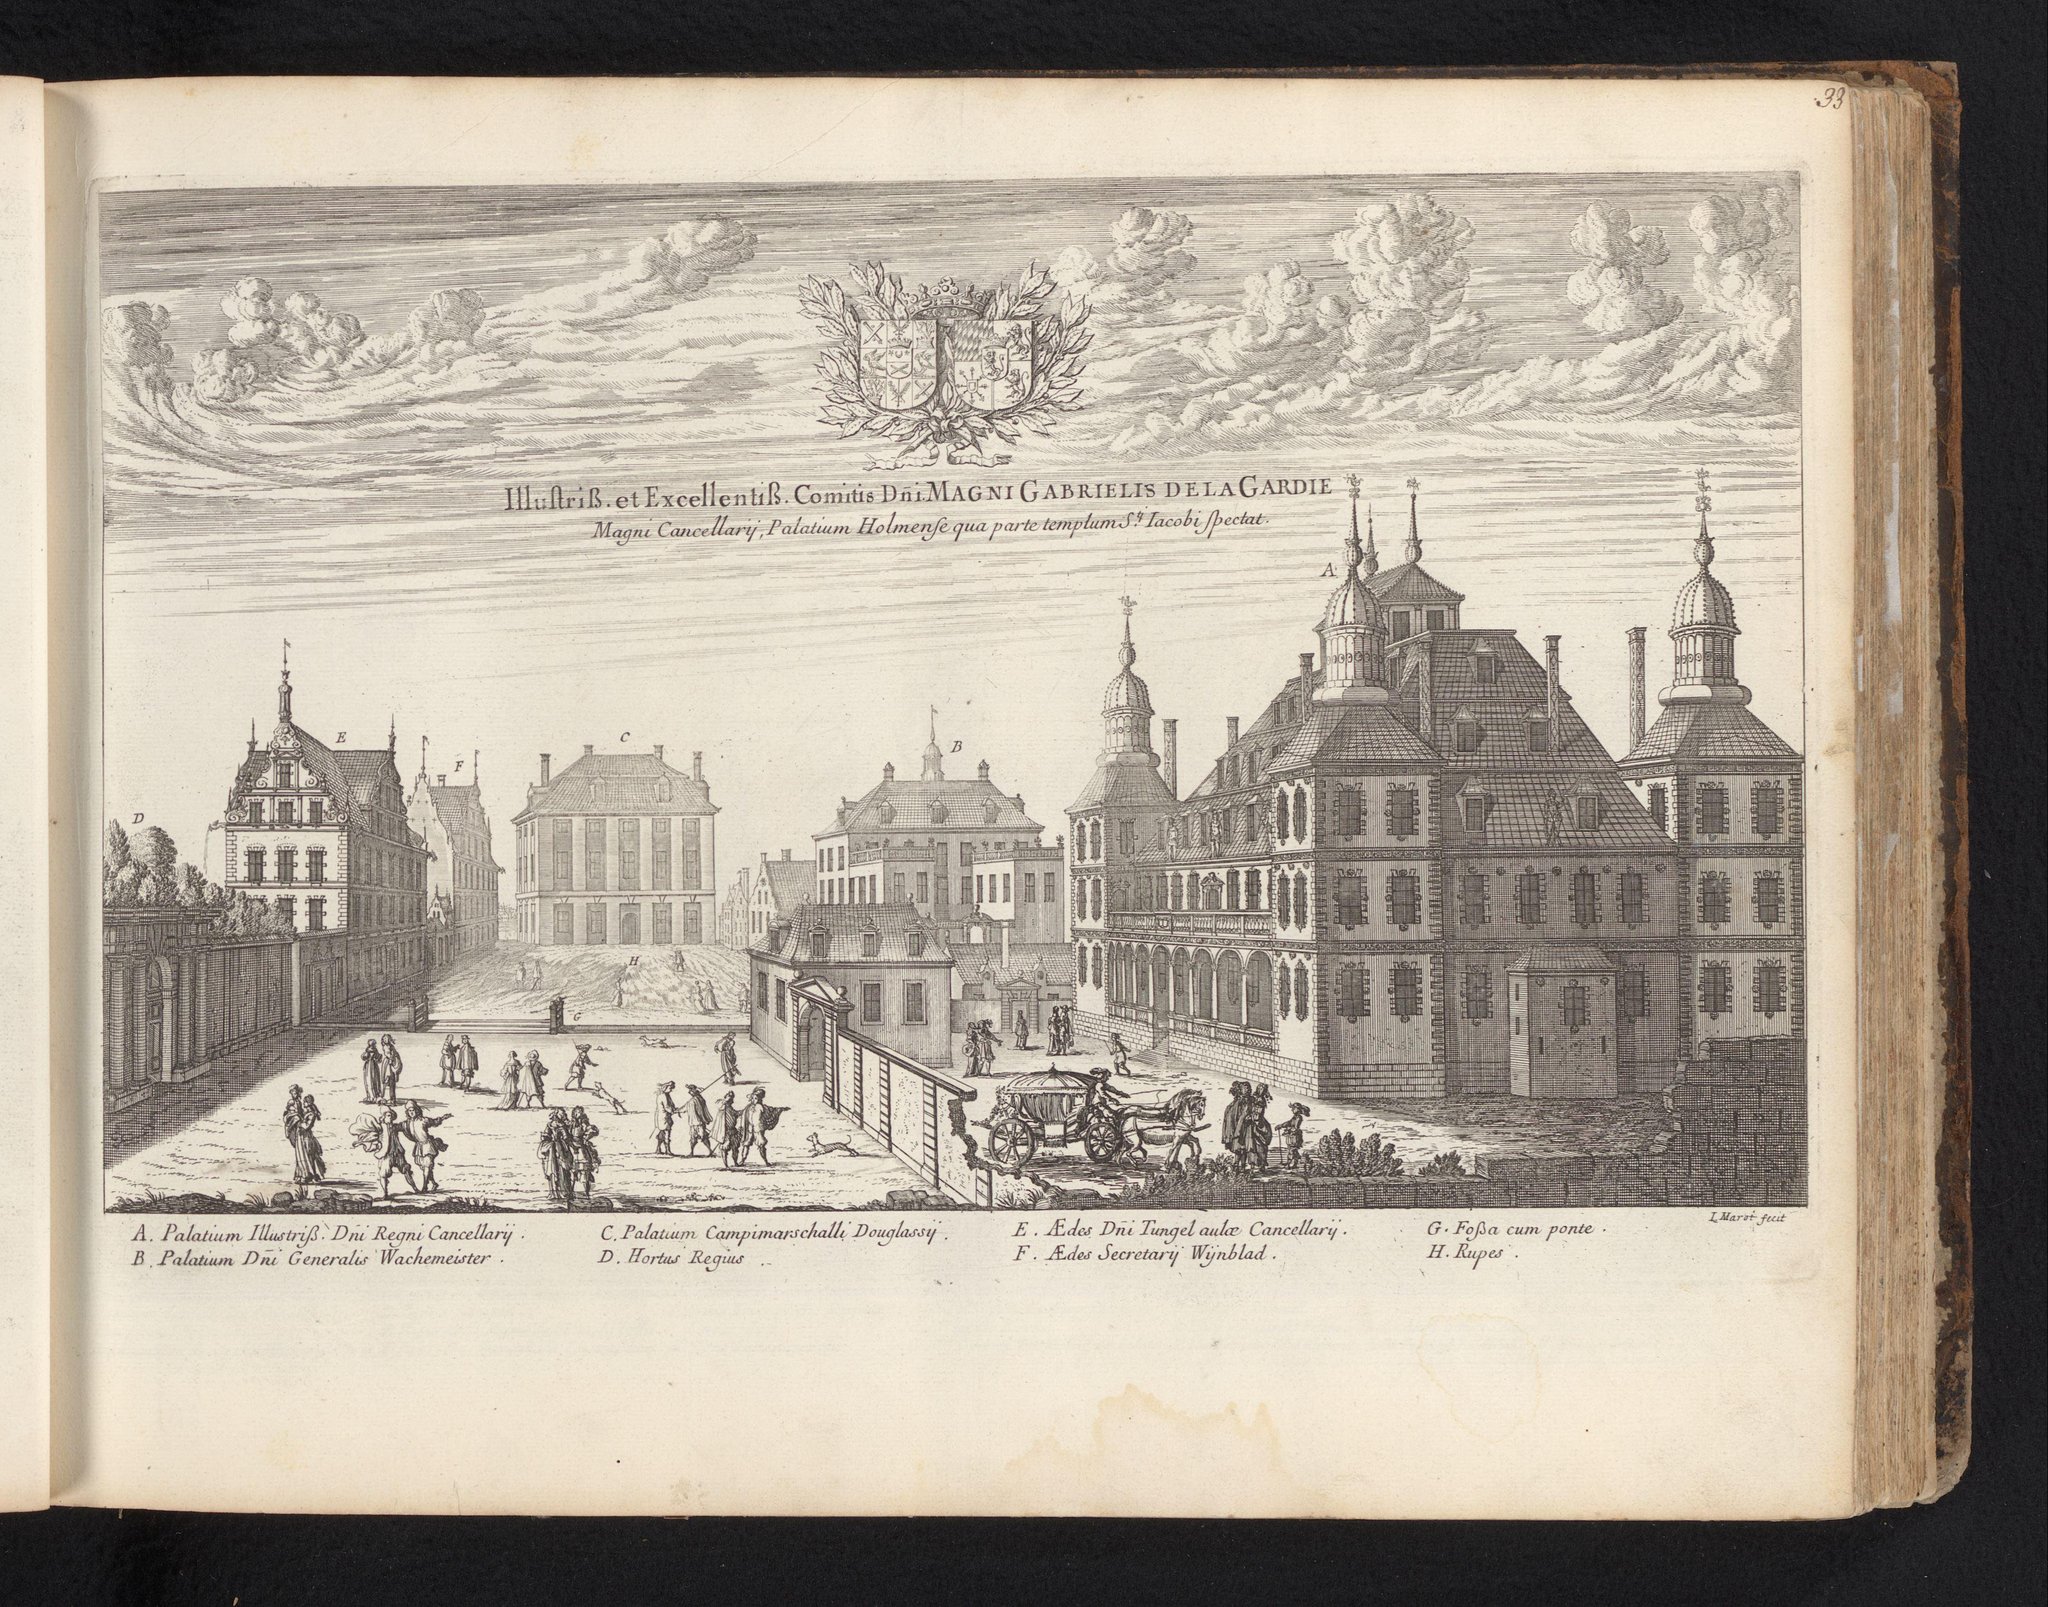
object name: print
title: Paleis van Magnus Gabriel de la Gardie vanaf de Jacobskerk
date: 1670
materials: paper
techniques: etching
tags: palace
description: Kungliga Biblioteket, 'Suecia': http://www.kb.se/samlingarna/Kartor-bilder/Suecia-antiqua/ (geraadpleegd november 2016).